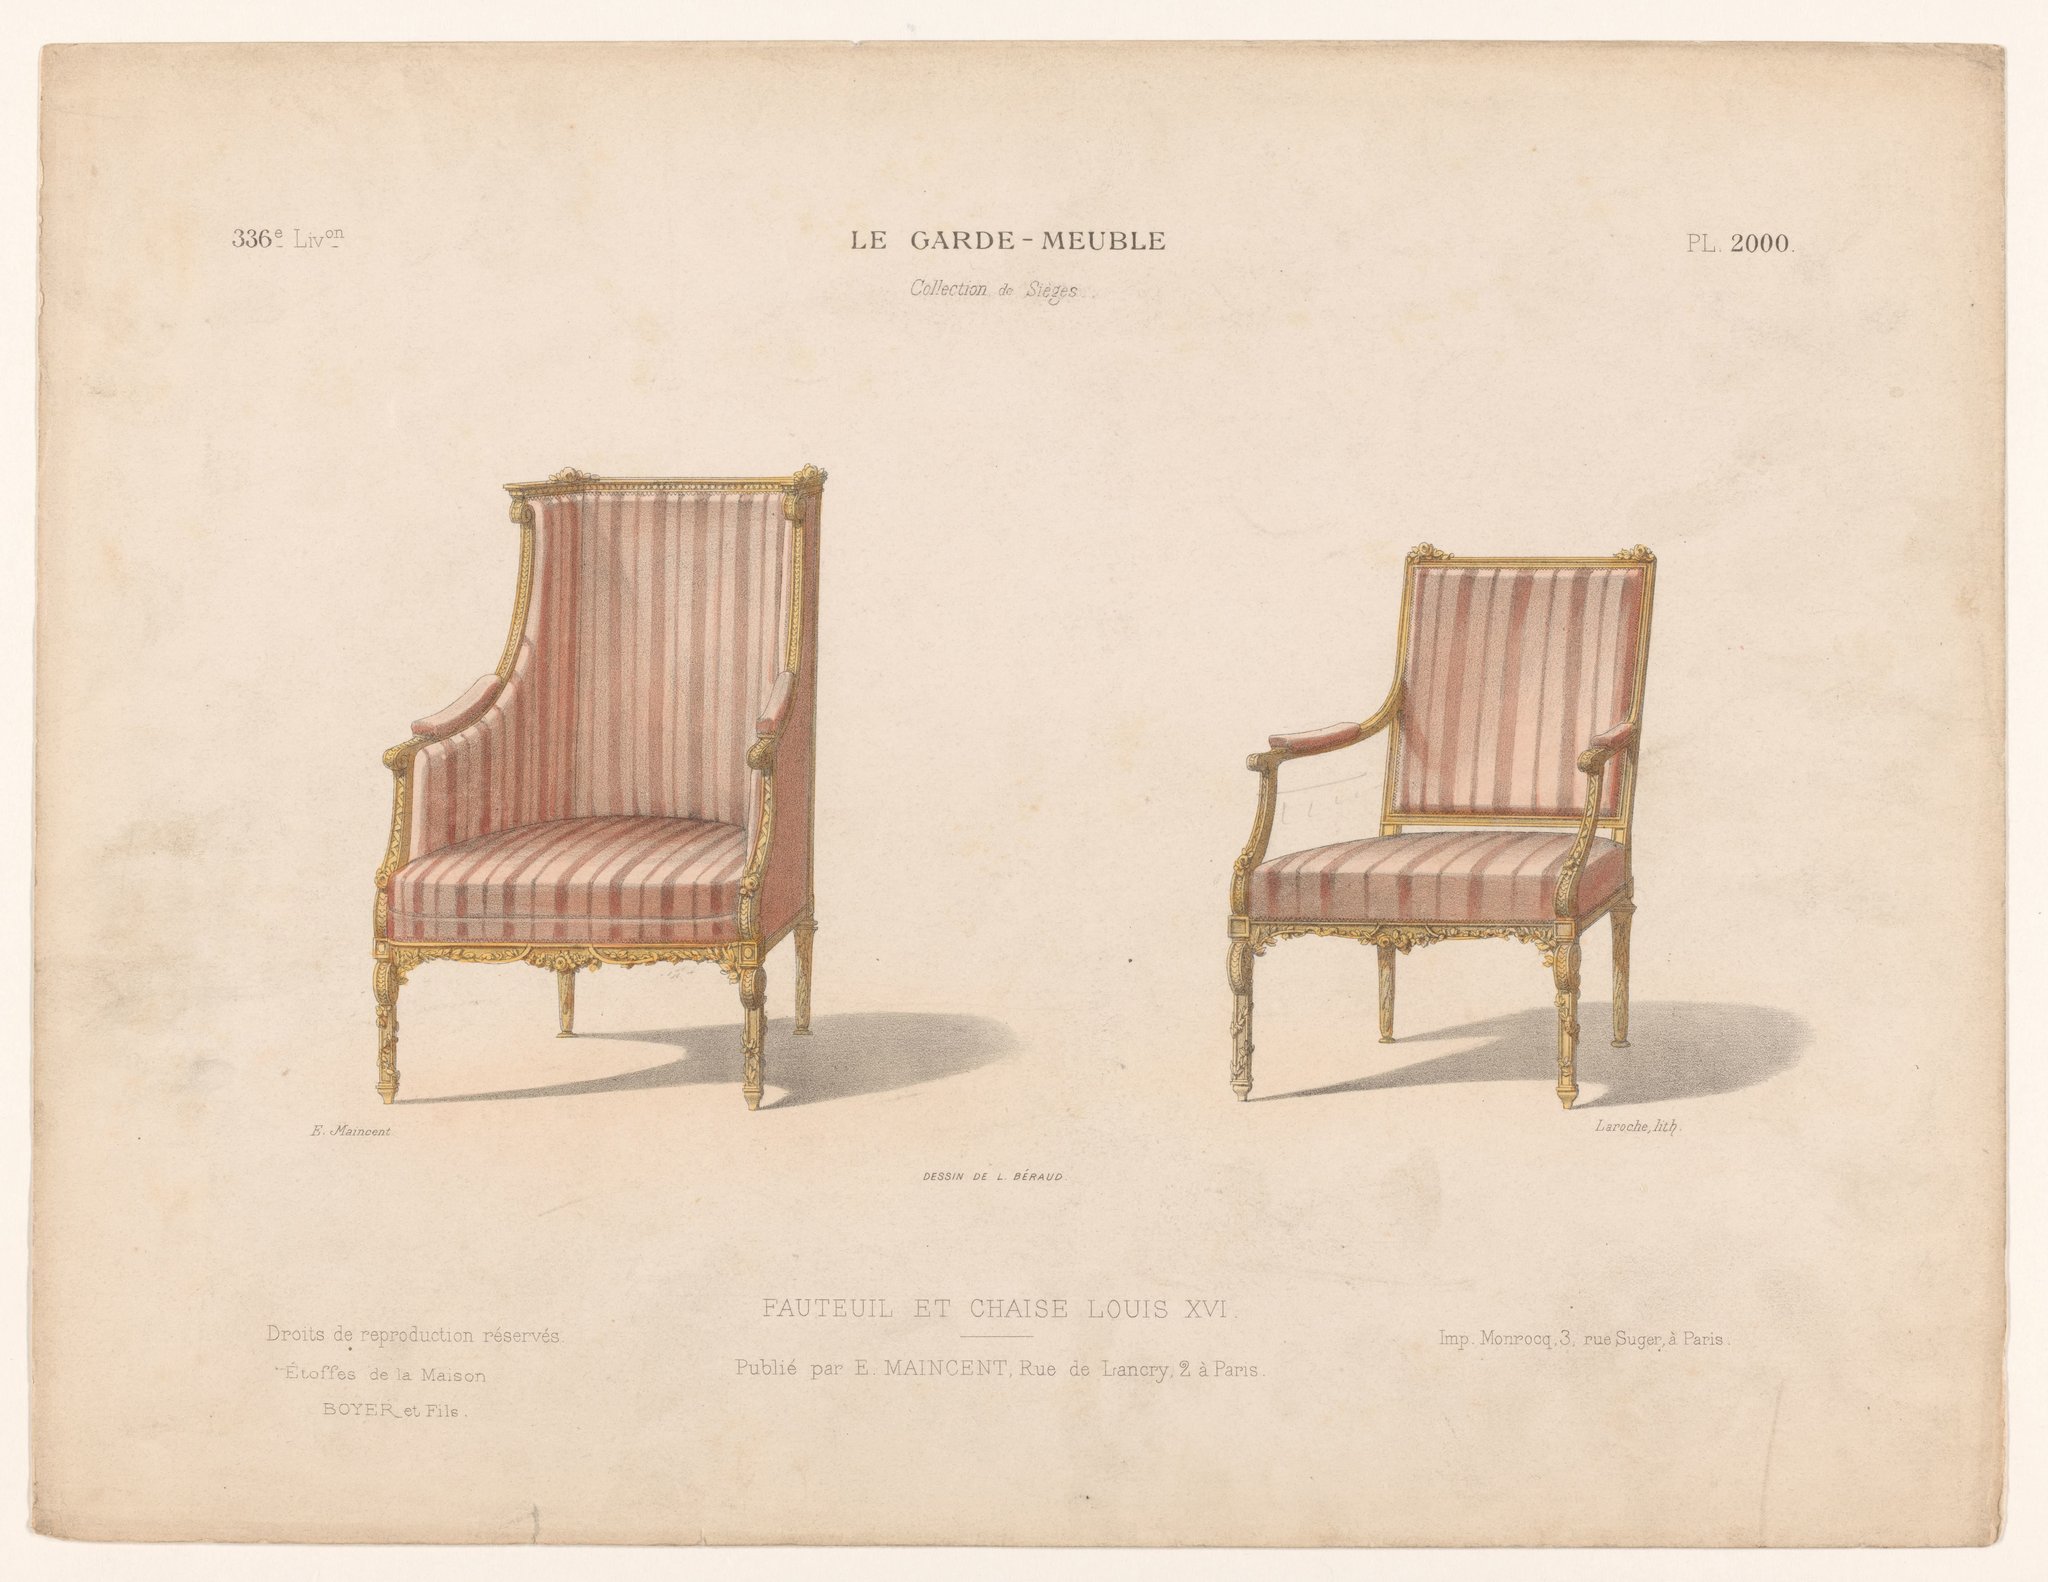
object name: print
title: Le garde-meuble / Collection de Sièges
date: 1885-1895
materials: paper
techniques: hand coloring, lithograph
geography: paris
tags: seating furniture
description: Ieder Livraison in de serie Le Garde-Meuble bevat negen platen: drie 'sièges' (zitmeubels), drie 'meubles' (diverse meubels zoals tafels en kasten) en drie 'tentures' (gordijnen en draperieën).